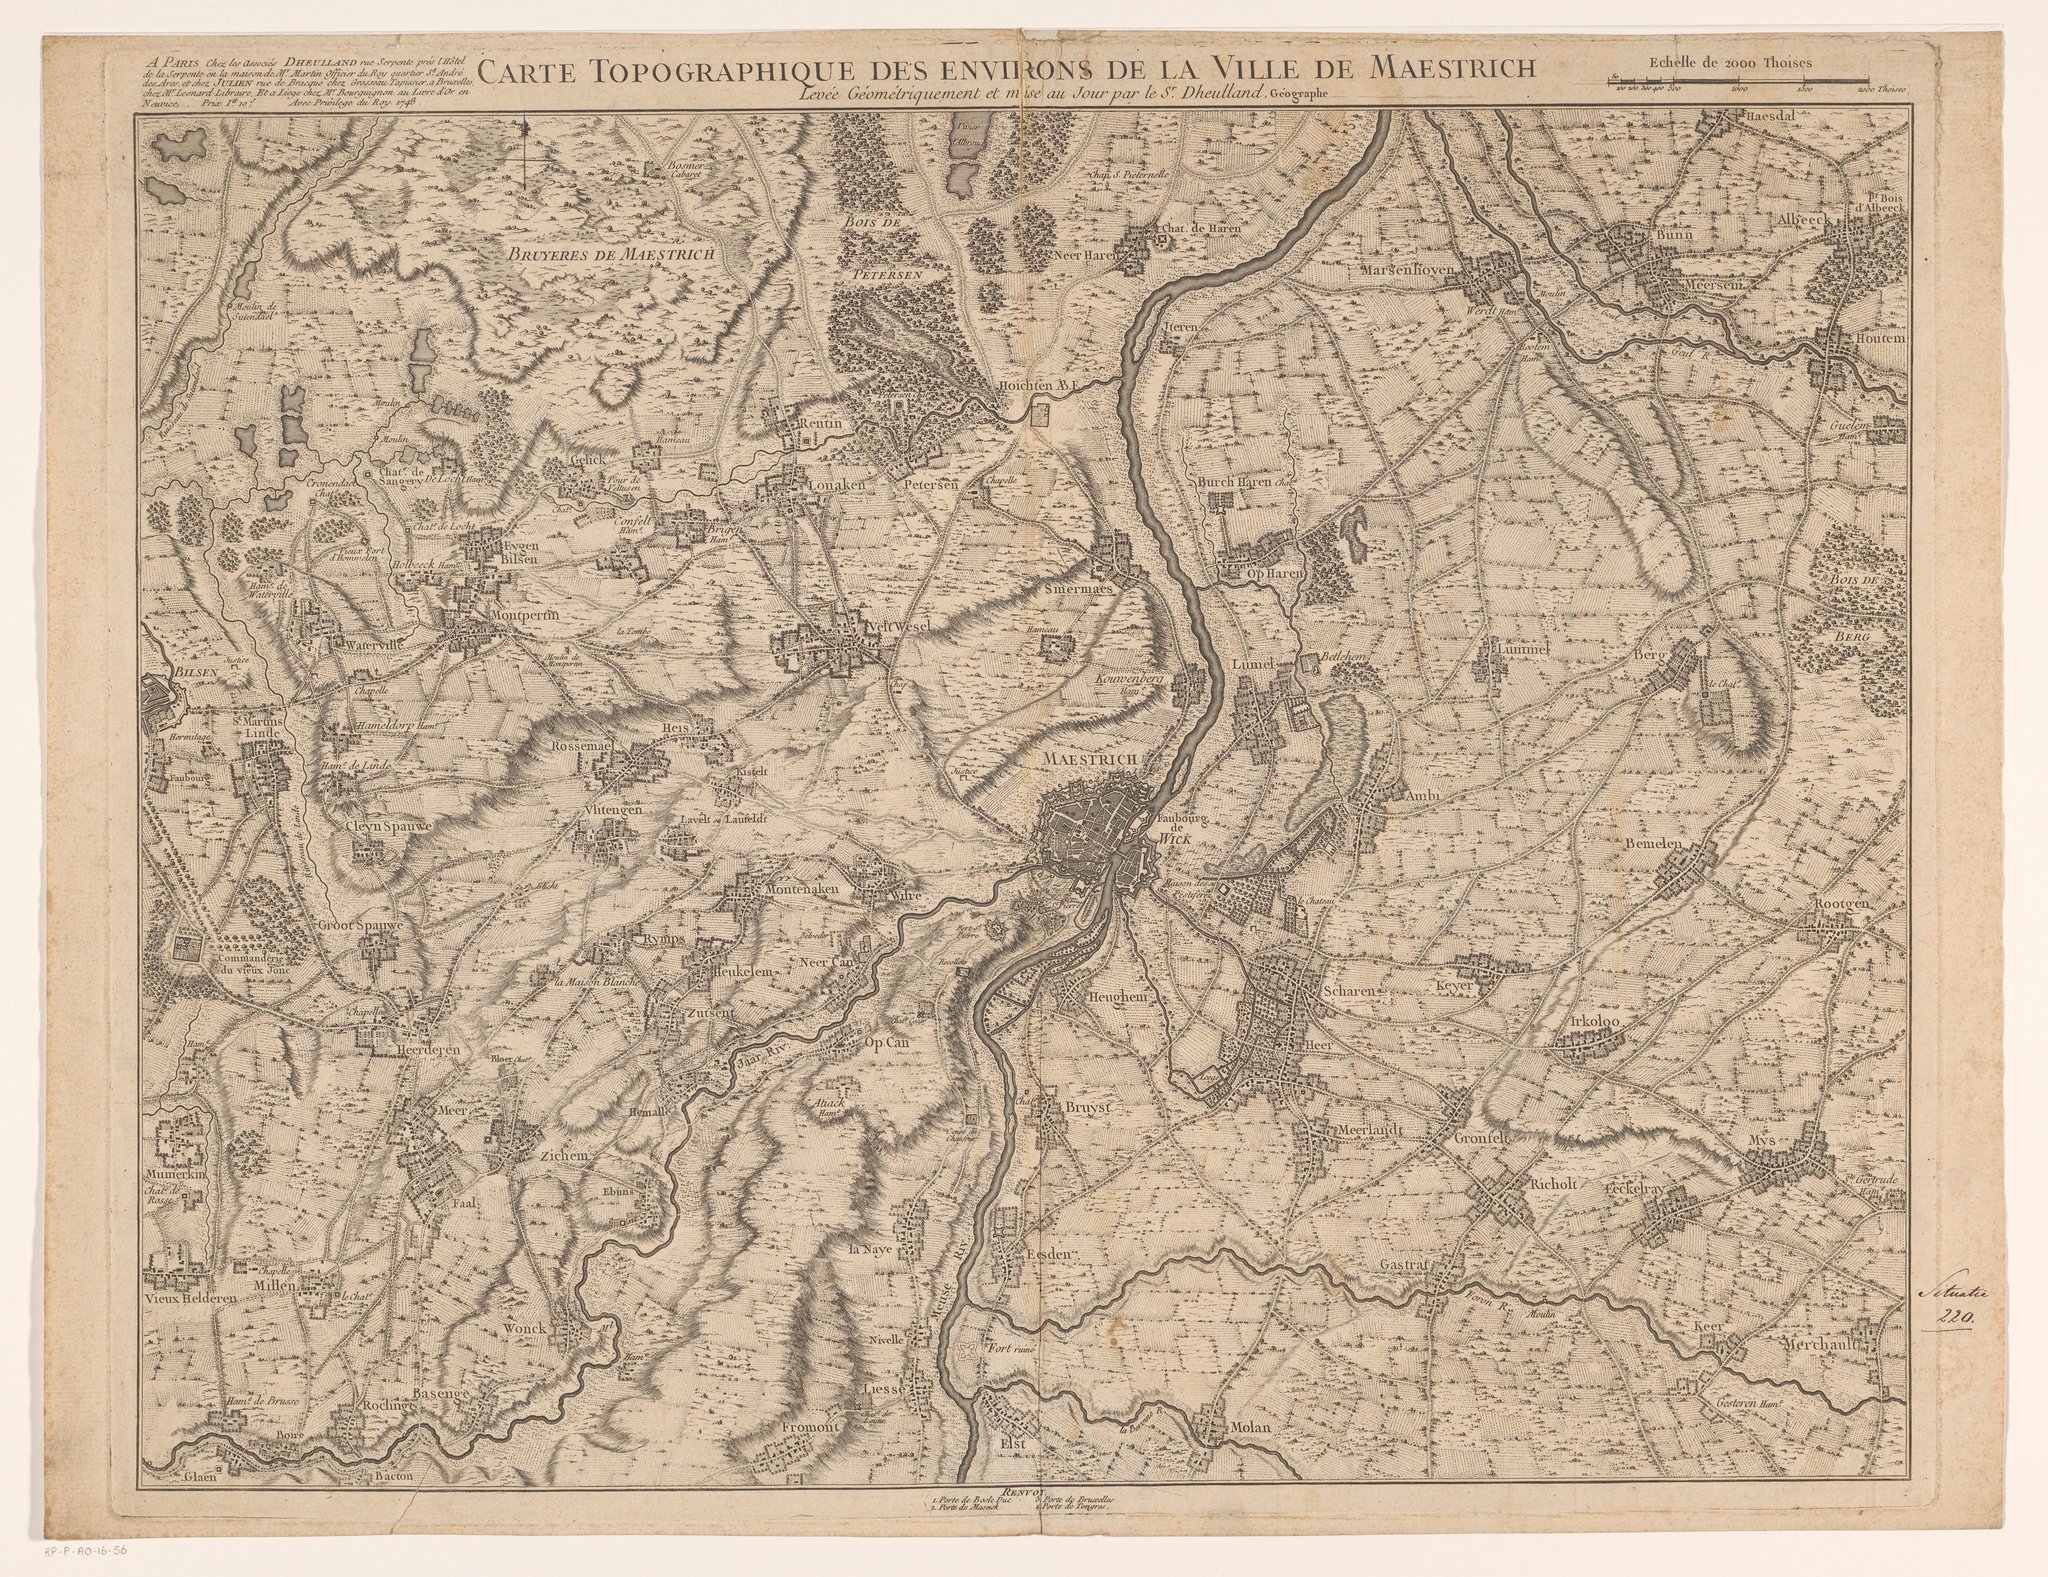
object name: map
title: Kaart van de omgeving van Maastricht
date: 1748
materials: paper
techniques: engraving, etching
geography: liège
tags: maps of separate countries or regions, maastricht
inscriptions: check stamp: ‘Archief Ministerie van Oorlog Afdeeling Genie’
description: Kaart van de omgeving van Maastricht. Boven, in het midden, de titel. Rechts daarvan een schaalstok: Echelle de 2000 Thoises. Onder, in het midden, een legenda 1-4.